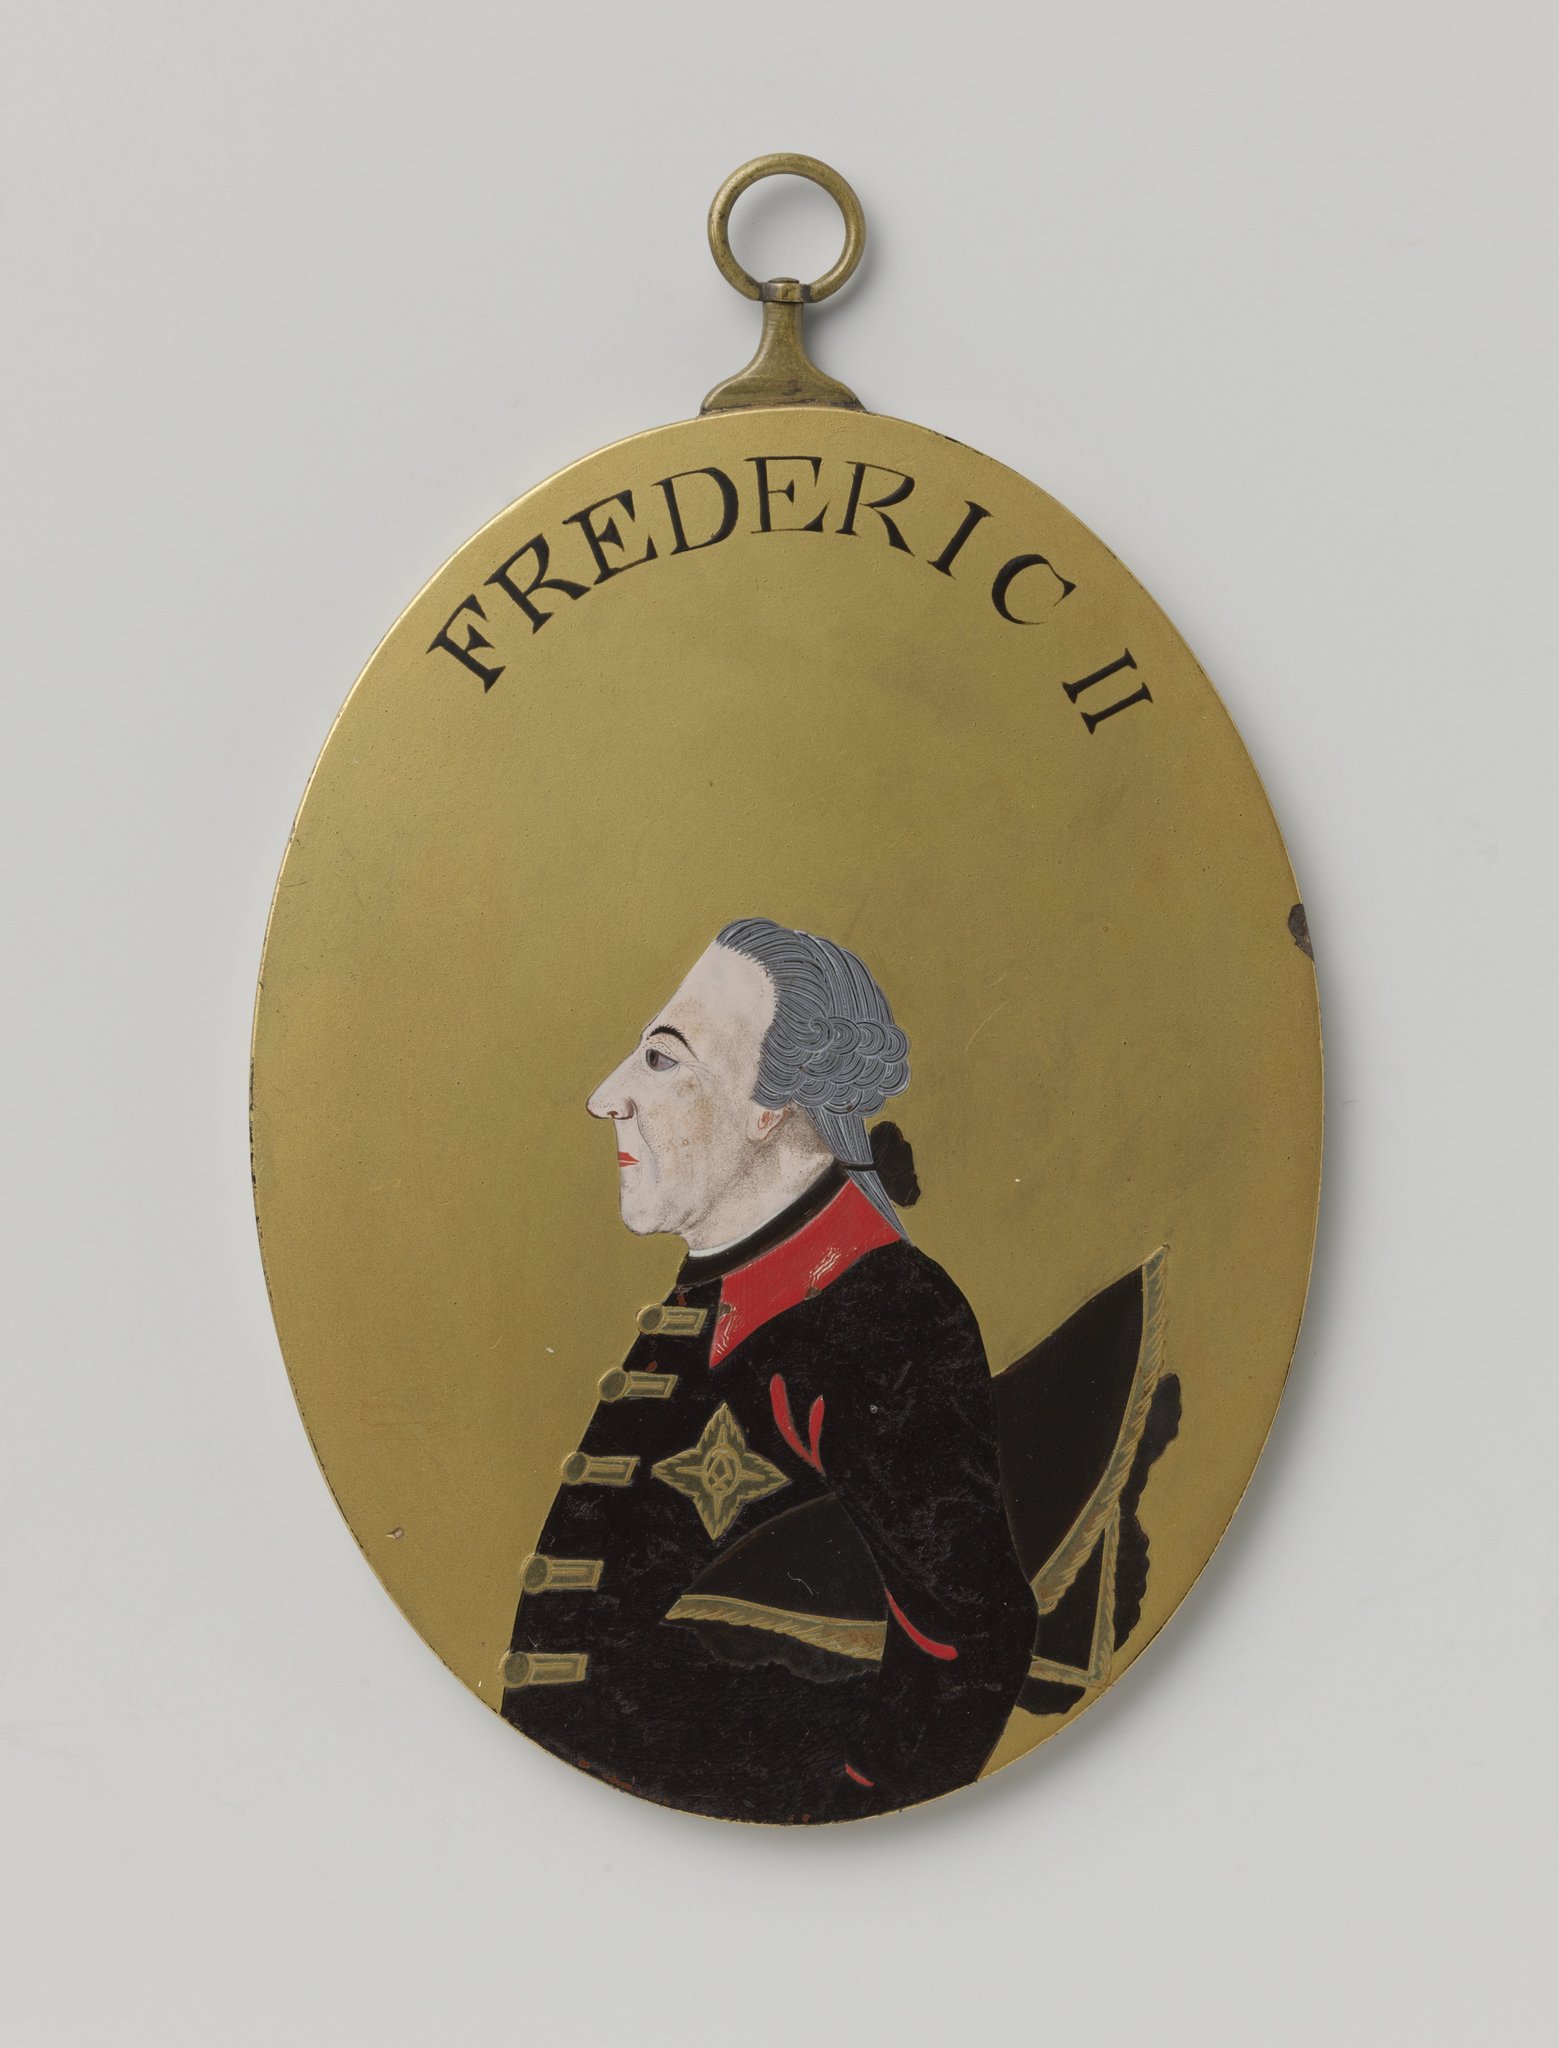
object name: plaque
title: Frederik II van Pruisen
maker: Anonymous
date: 1775-1800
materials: copper, lacquer, mother of pearl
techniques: lacquer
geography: japan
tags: berlin, frederick ii (king of prussia)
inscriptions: inscription: ‘Roi de Pruße et Electeur de Brandebourg’, circumscription: ‘FREDERIC II’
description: Portraits of European monarchs and scholars. Japan, last quarter 18th century. The VOC exported lacquer products commissioned specifically for the European market. Working from European prints, Japanese craftsmen made series of portraits for the VOC.